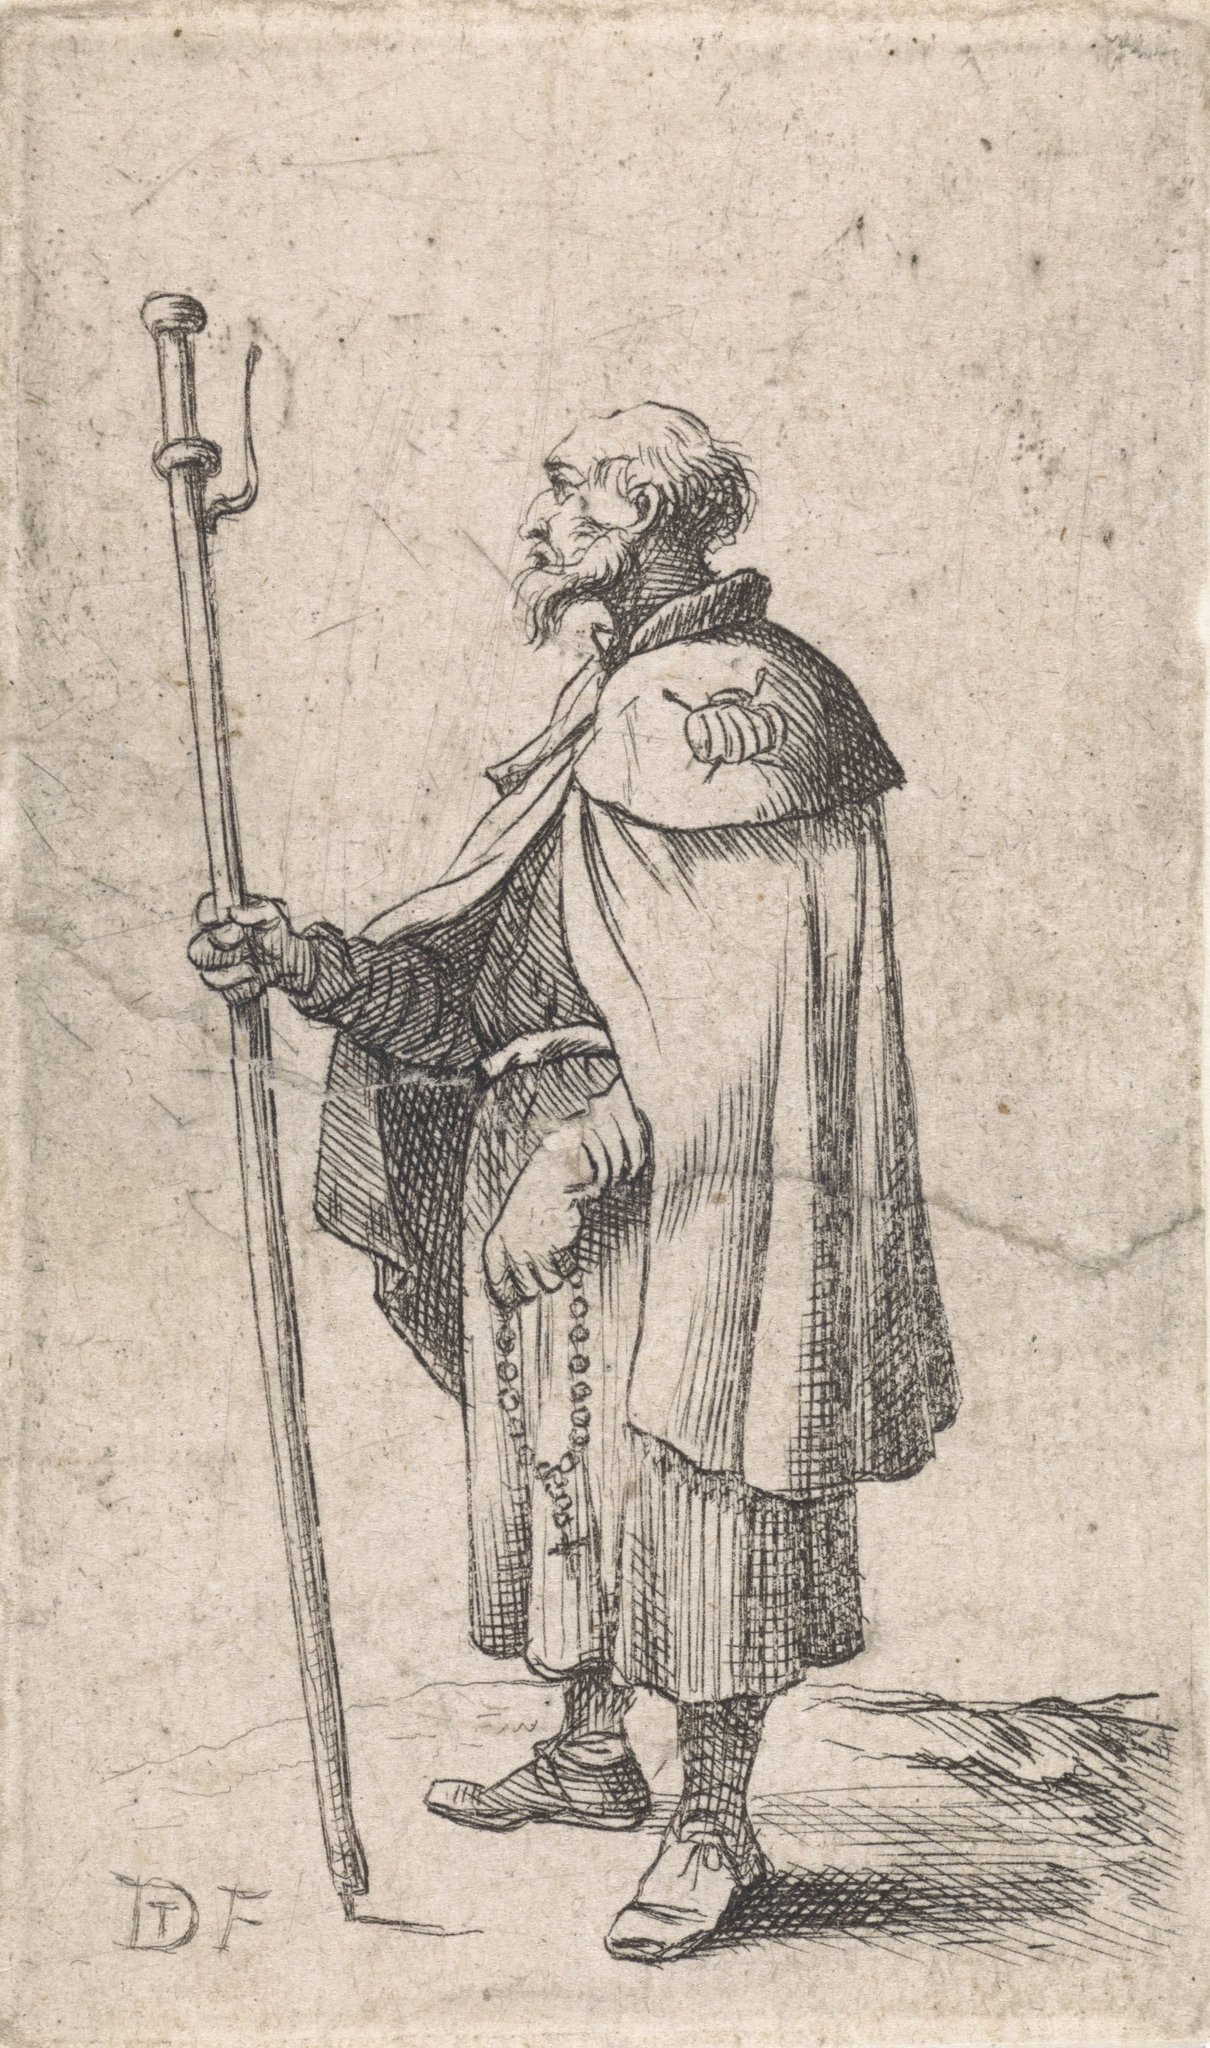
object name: print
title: Pelgrim met gebedssnoer en staf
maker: david teniers (ii)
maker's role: draughtsman, painter, print maker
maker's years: 1610-1690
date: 1626-1690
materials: paper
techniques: engraving, etching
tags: pilgrim(s)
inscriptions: collector's mark: Lugt 2228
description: Een pelgrim met een gebedssnoer in de linker- en een staf in de rechterhand. Op zijn mantel een Jacobsschelp.